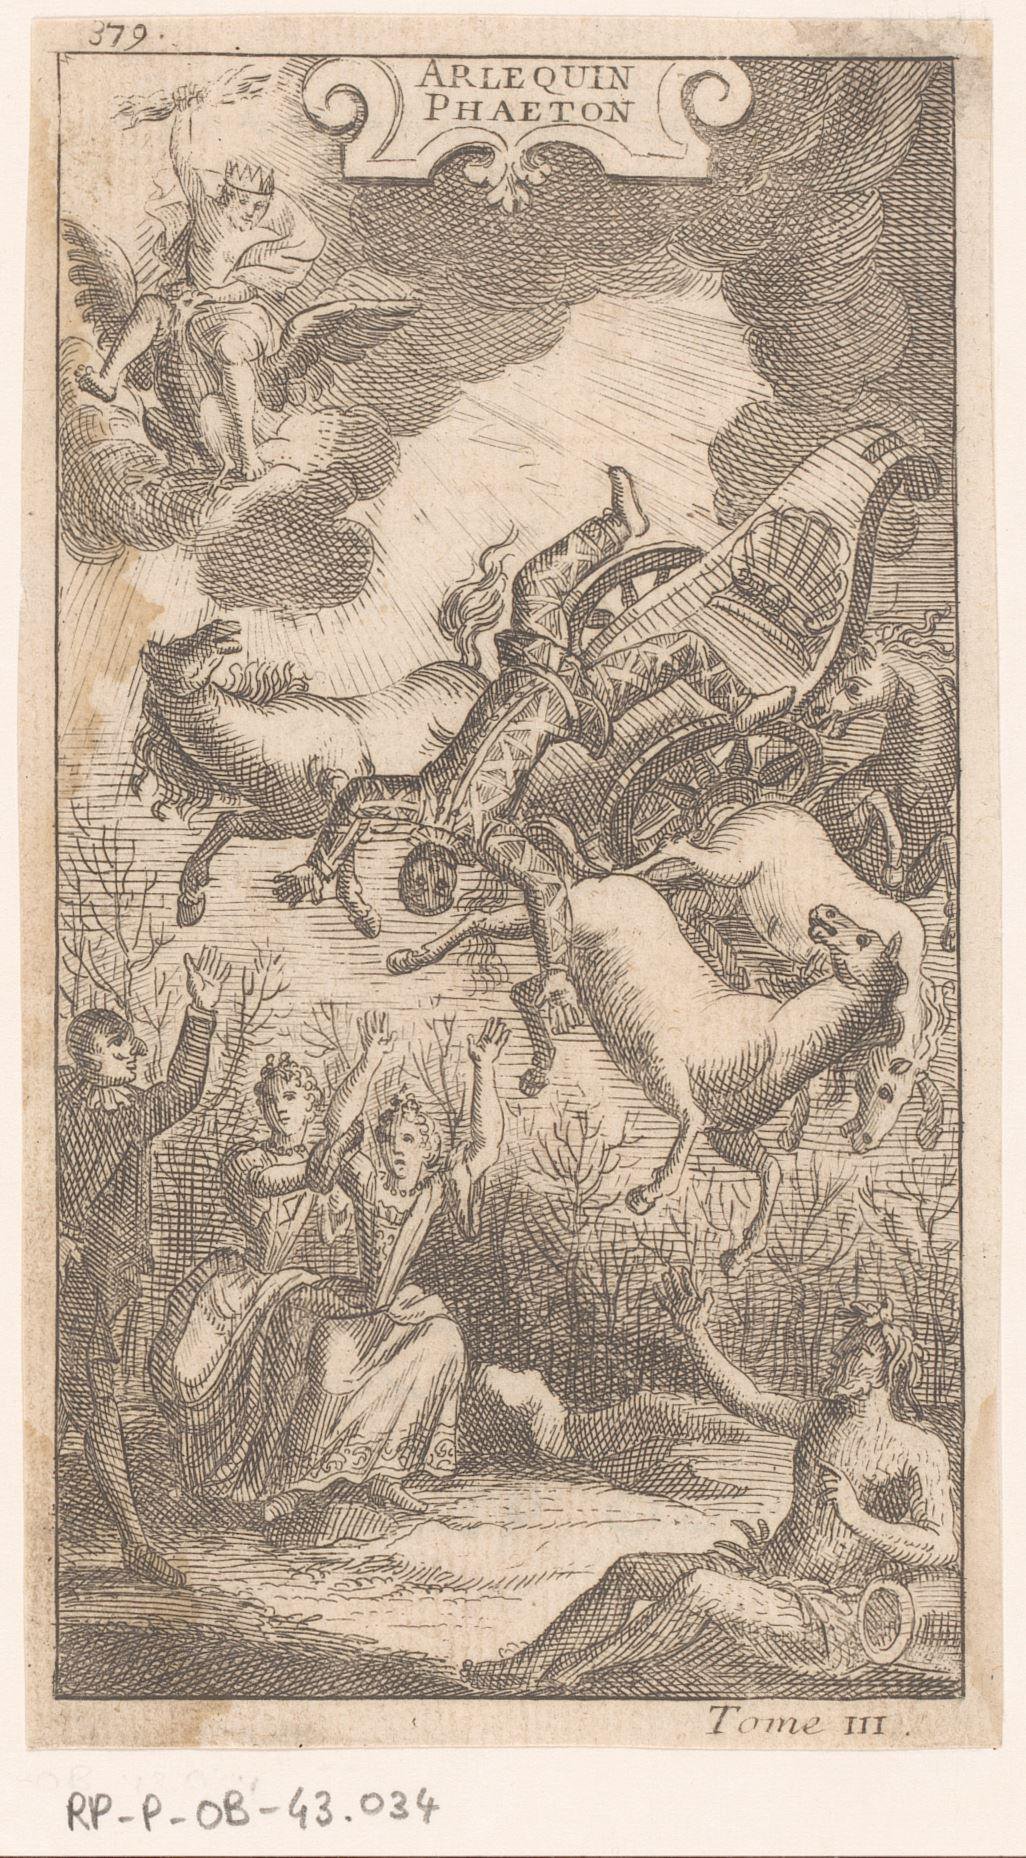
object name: print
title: Val van Phaëton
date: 1741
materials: paper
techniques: etching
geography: paris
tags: theatre, theatrical performance, phaethon, types in 'commedia dell'arte': harlequin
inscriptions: collector's mark: Lugt 2228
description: Prent uit: Palaprat, Jean. Arlequin Phaëton. Parijs: Briason, 1741, dl. 3, p. 379. De illustratie is waarschijnlijk gebaseerd op een toneelstuk, getiteld 'Arlequin Phaeton', naar het theater gebracht door Monsieur de Palaprat en opgevoerd door de Comédiens Italiens du Roi in het Hôtel de Bourgogne op 4 februari 1691.